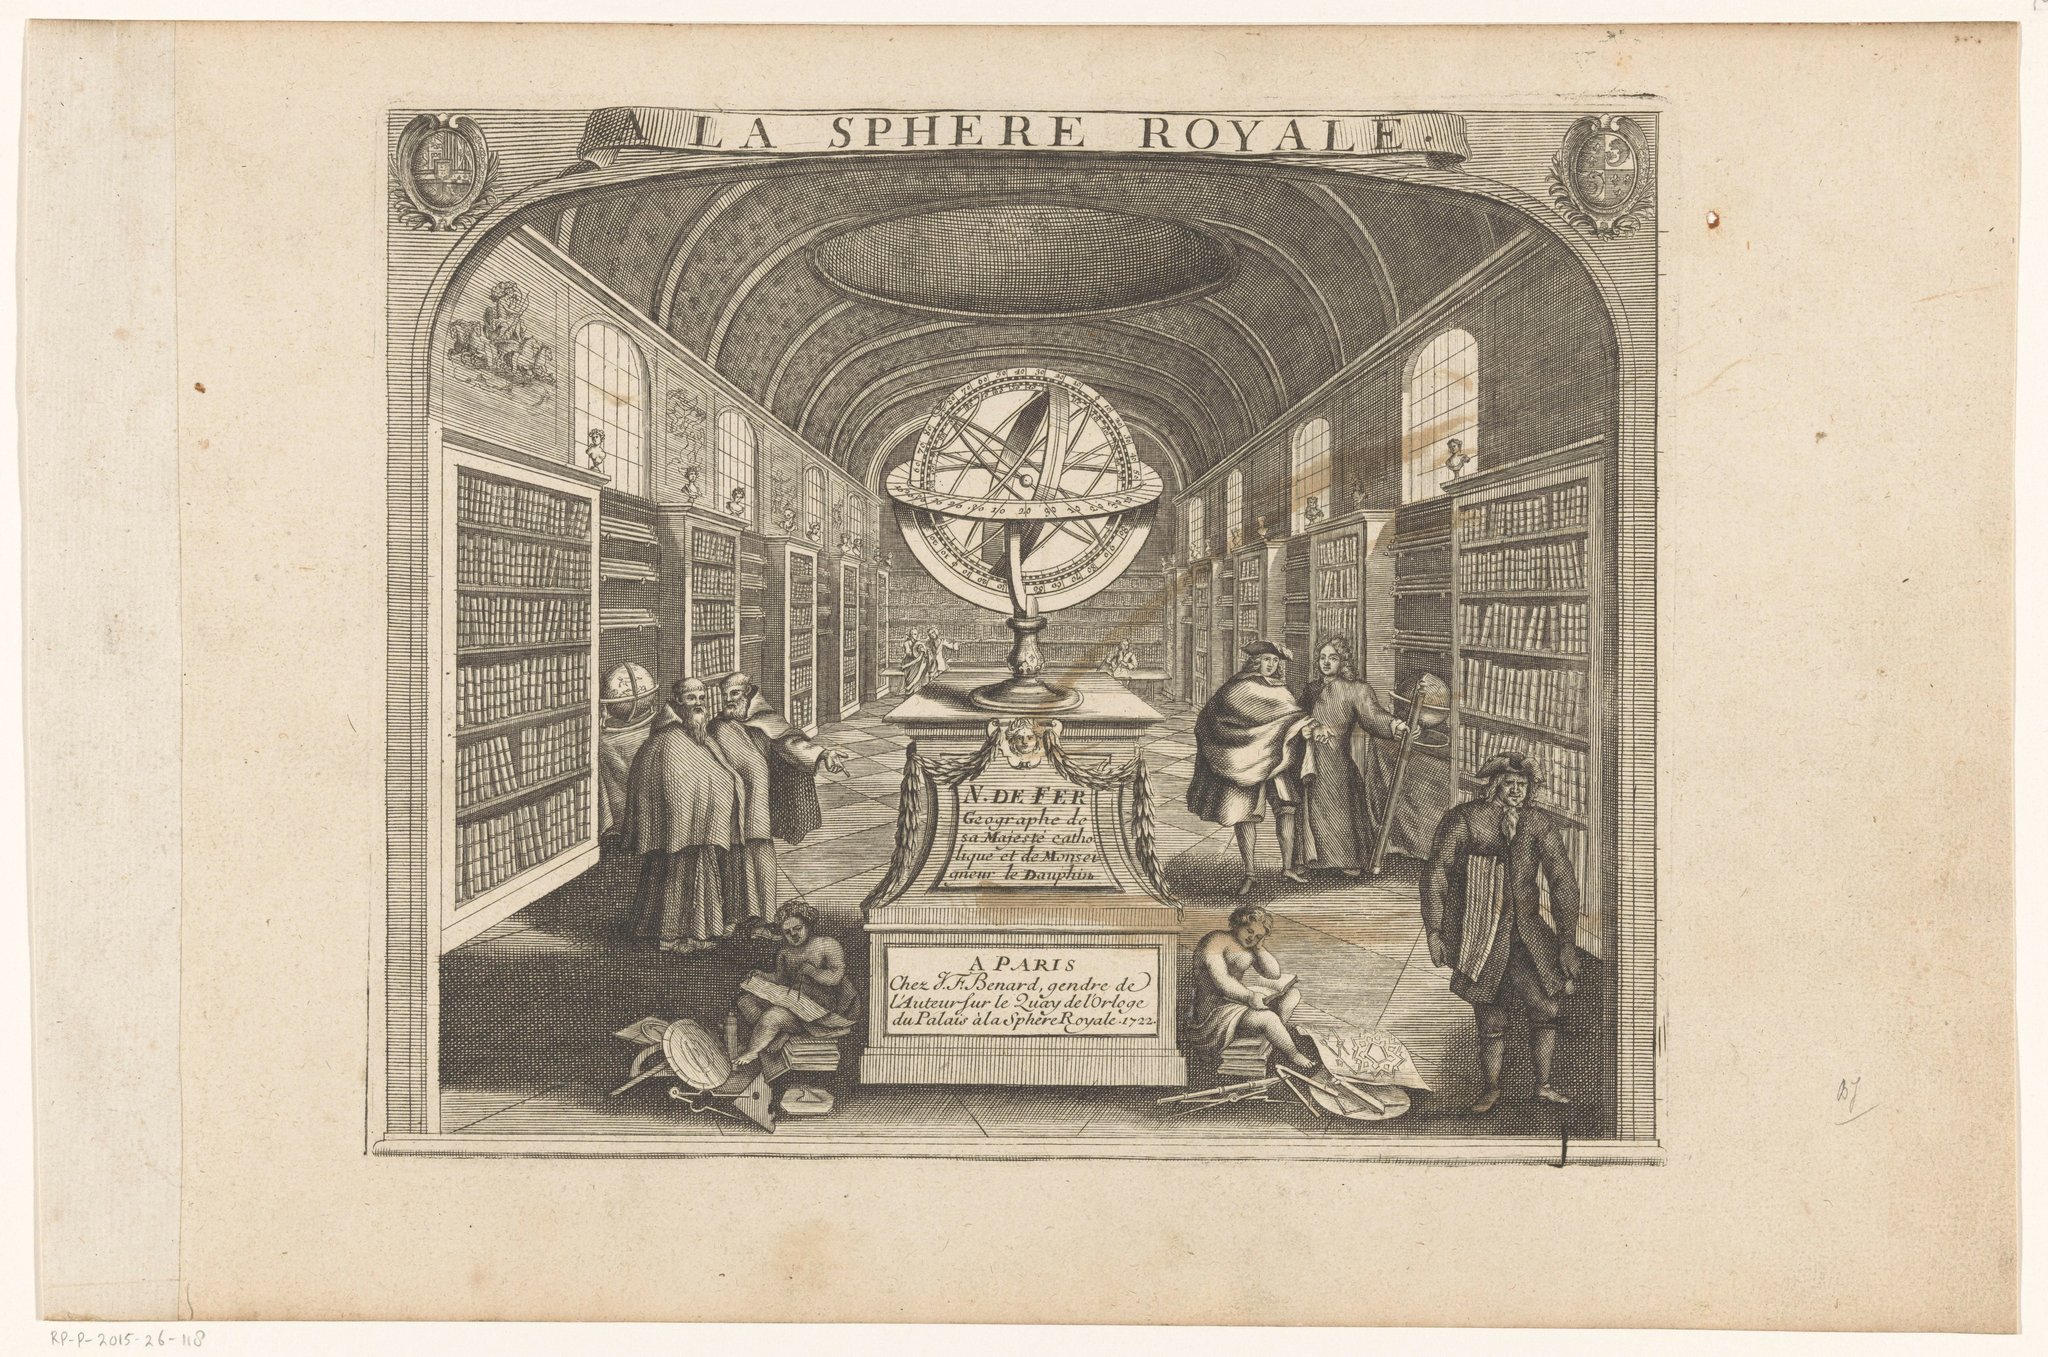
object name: print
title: A la Sphere Royale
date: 1722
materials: paper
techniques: engraving, etching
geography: paris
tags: publishing, publisher, armillary sphere, skeleton celestial globe, book-shop, bookseller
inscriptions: collector's mark: Lugt 2228, collector's mark: Lugt 4779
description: Interieur van de winkel van cartograaf, prentmaker en uitgever Nicolas de Fer aan le Quai de l'Horloge te Parijs, genaamd A la Sphere Royale. In een vertrek gevuld met boeken staan verschillende figuren. Op de voorgrond een hemelglobe met aan weerszijden putti.